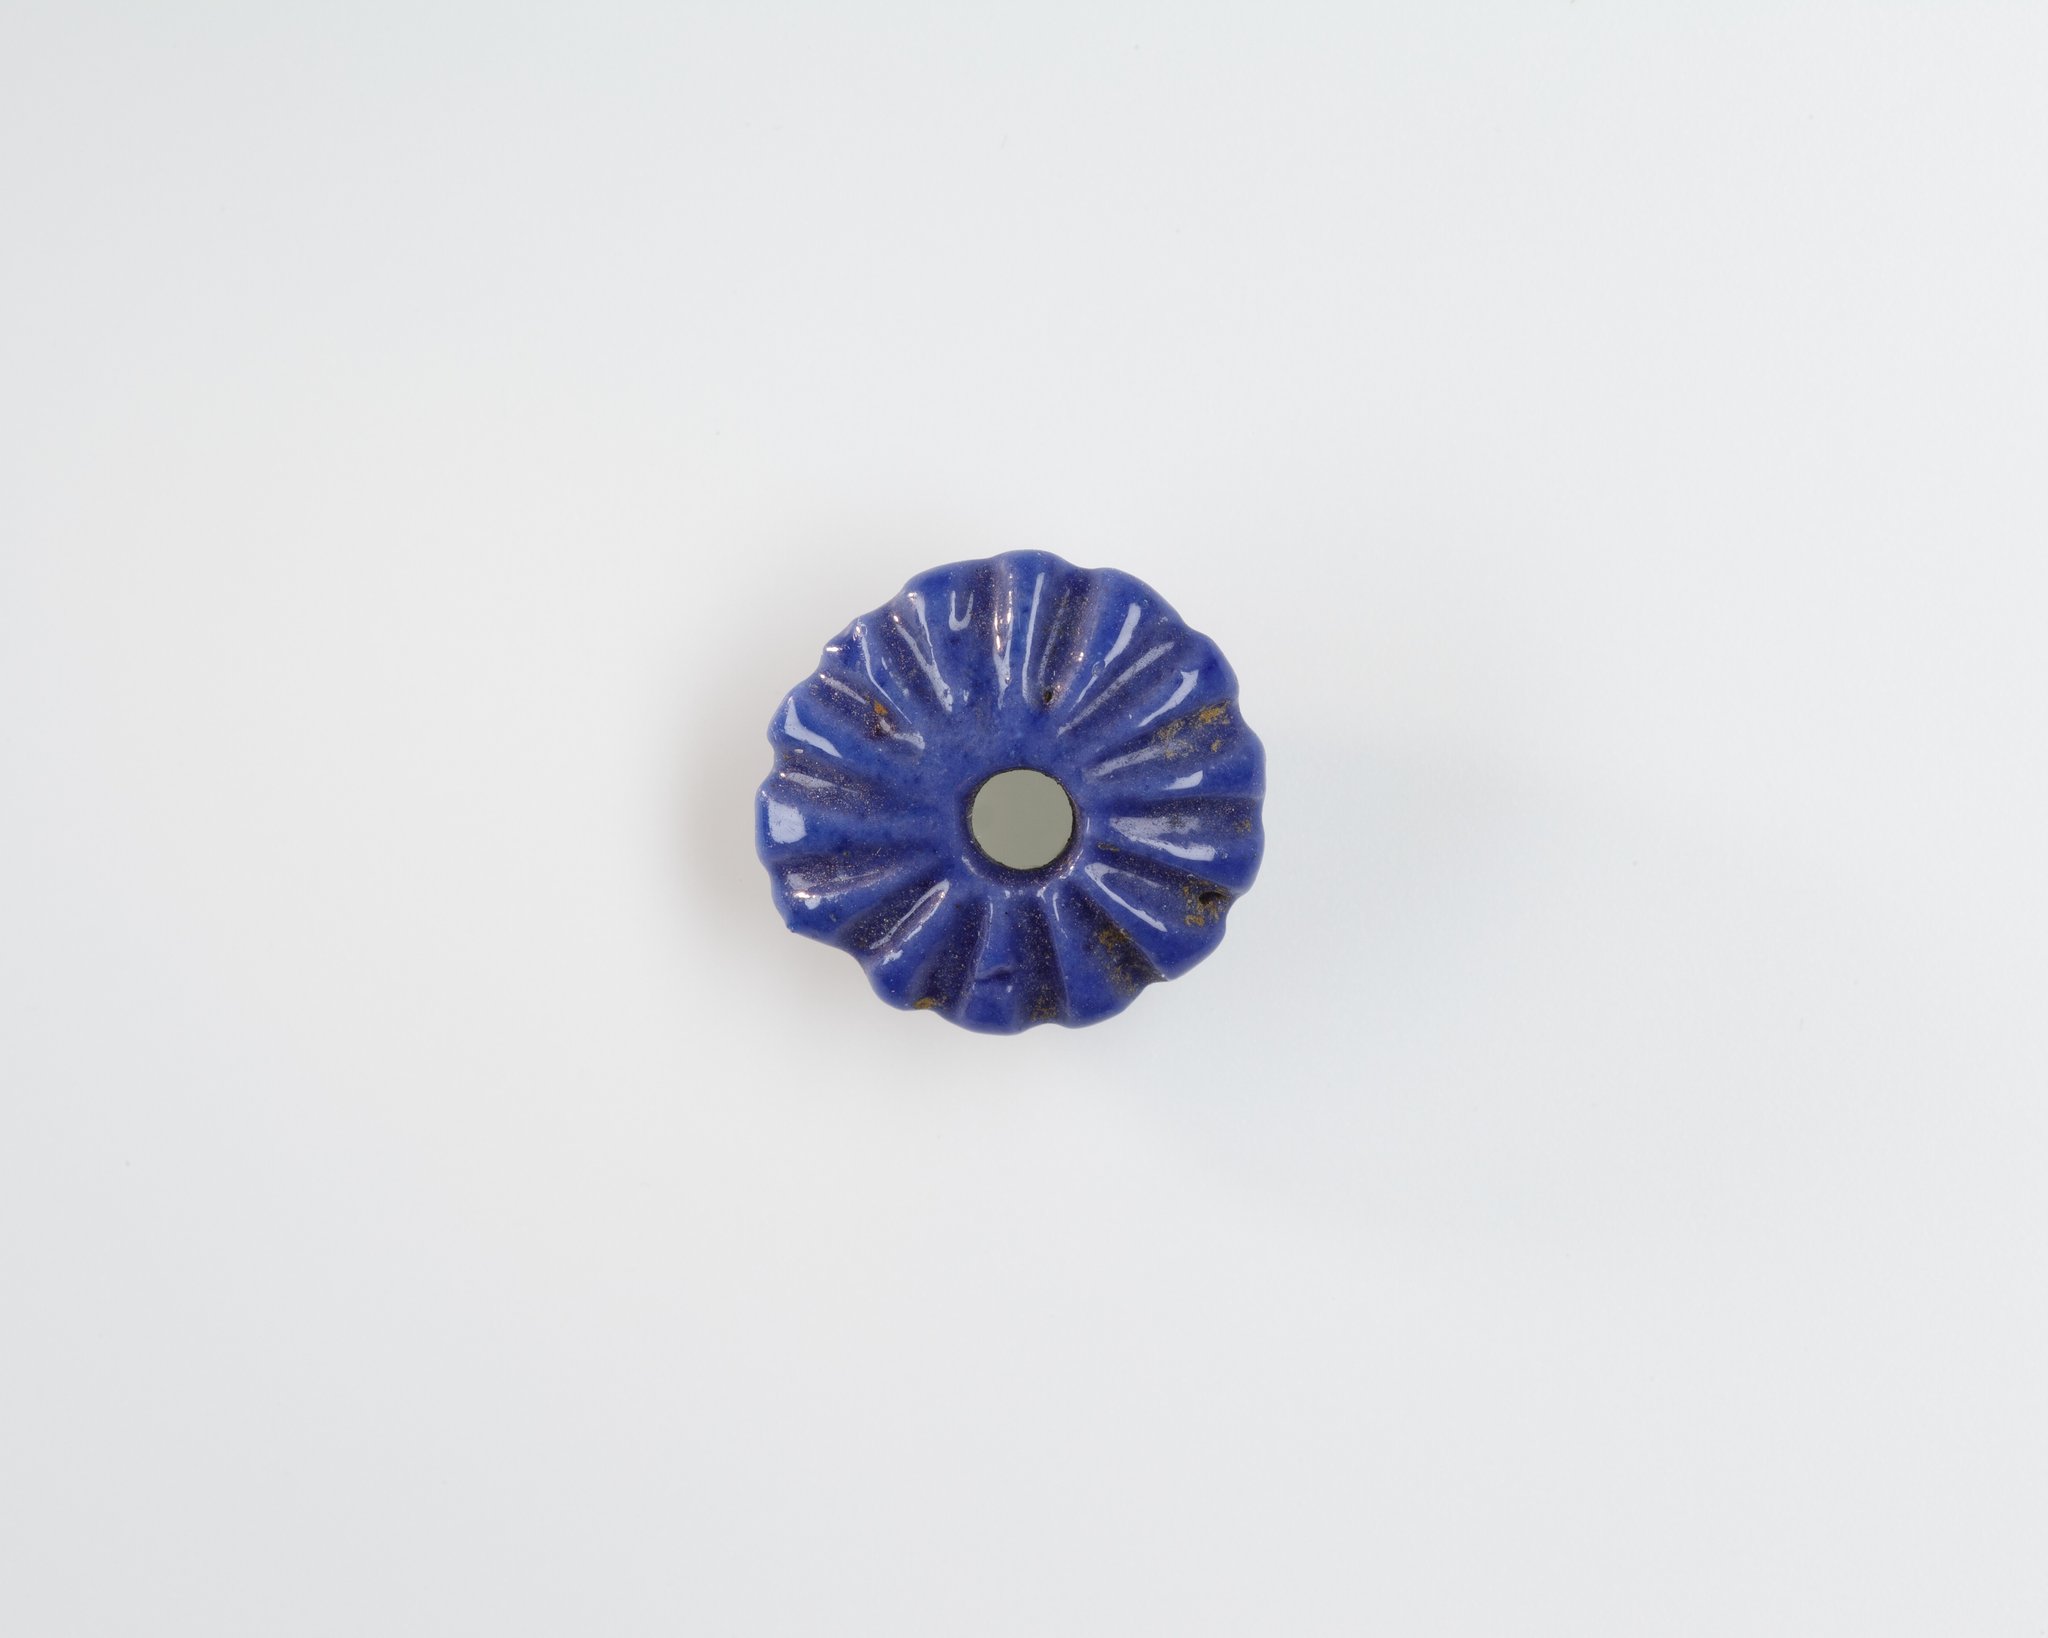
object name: pendant, rosette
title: Rosette Pendant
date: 1390-1352 BCE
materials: faience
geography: egypt